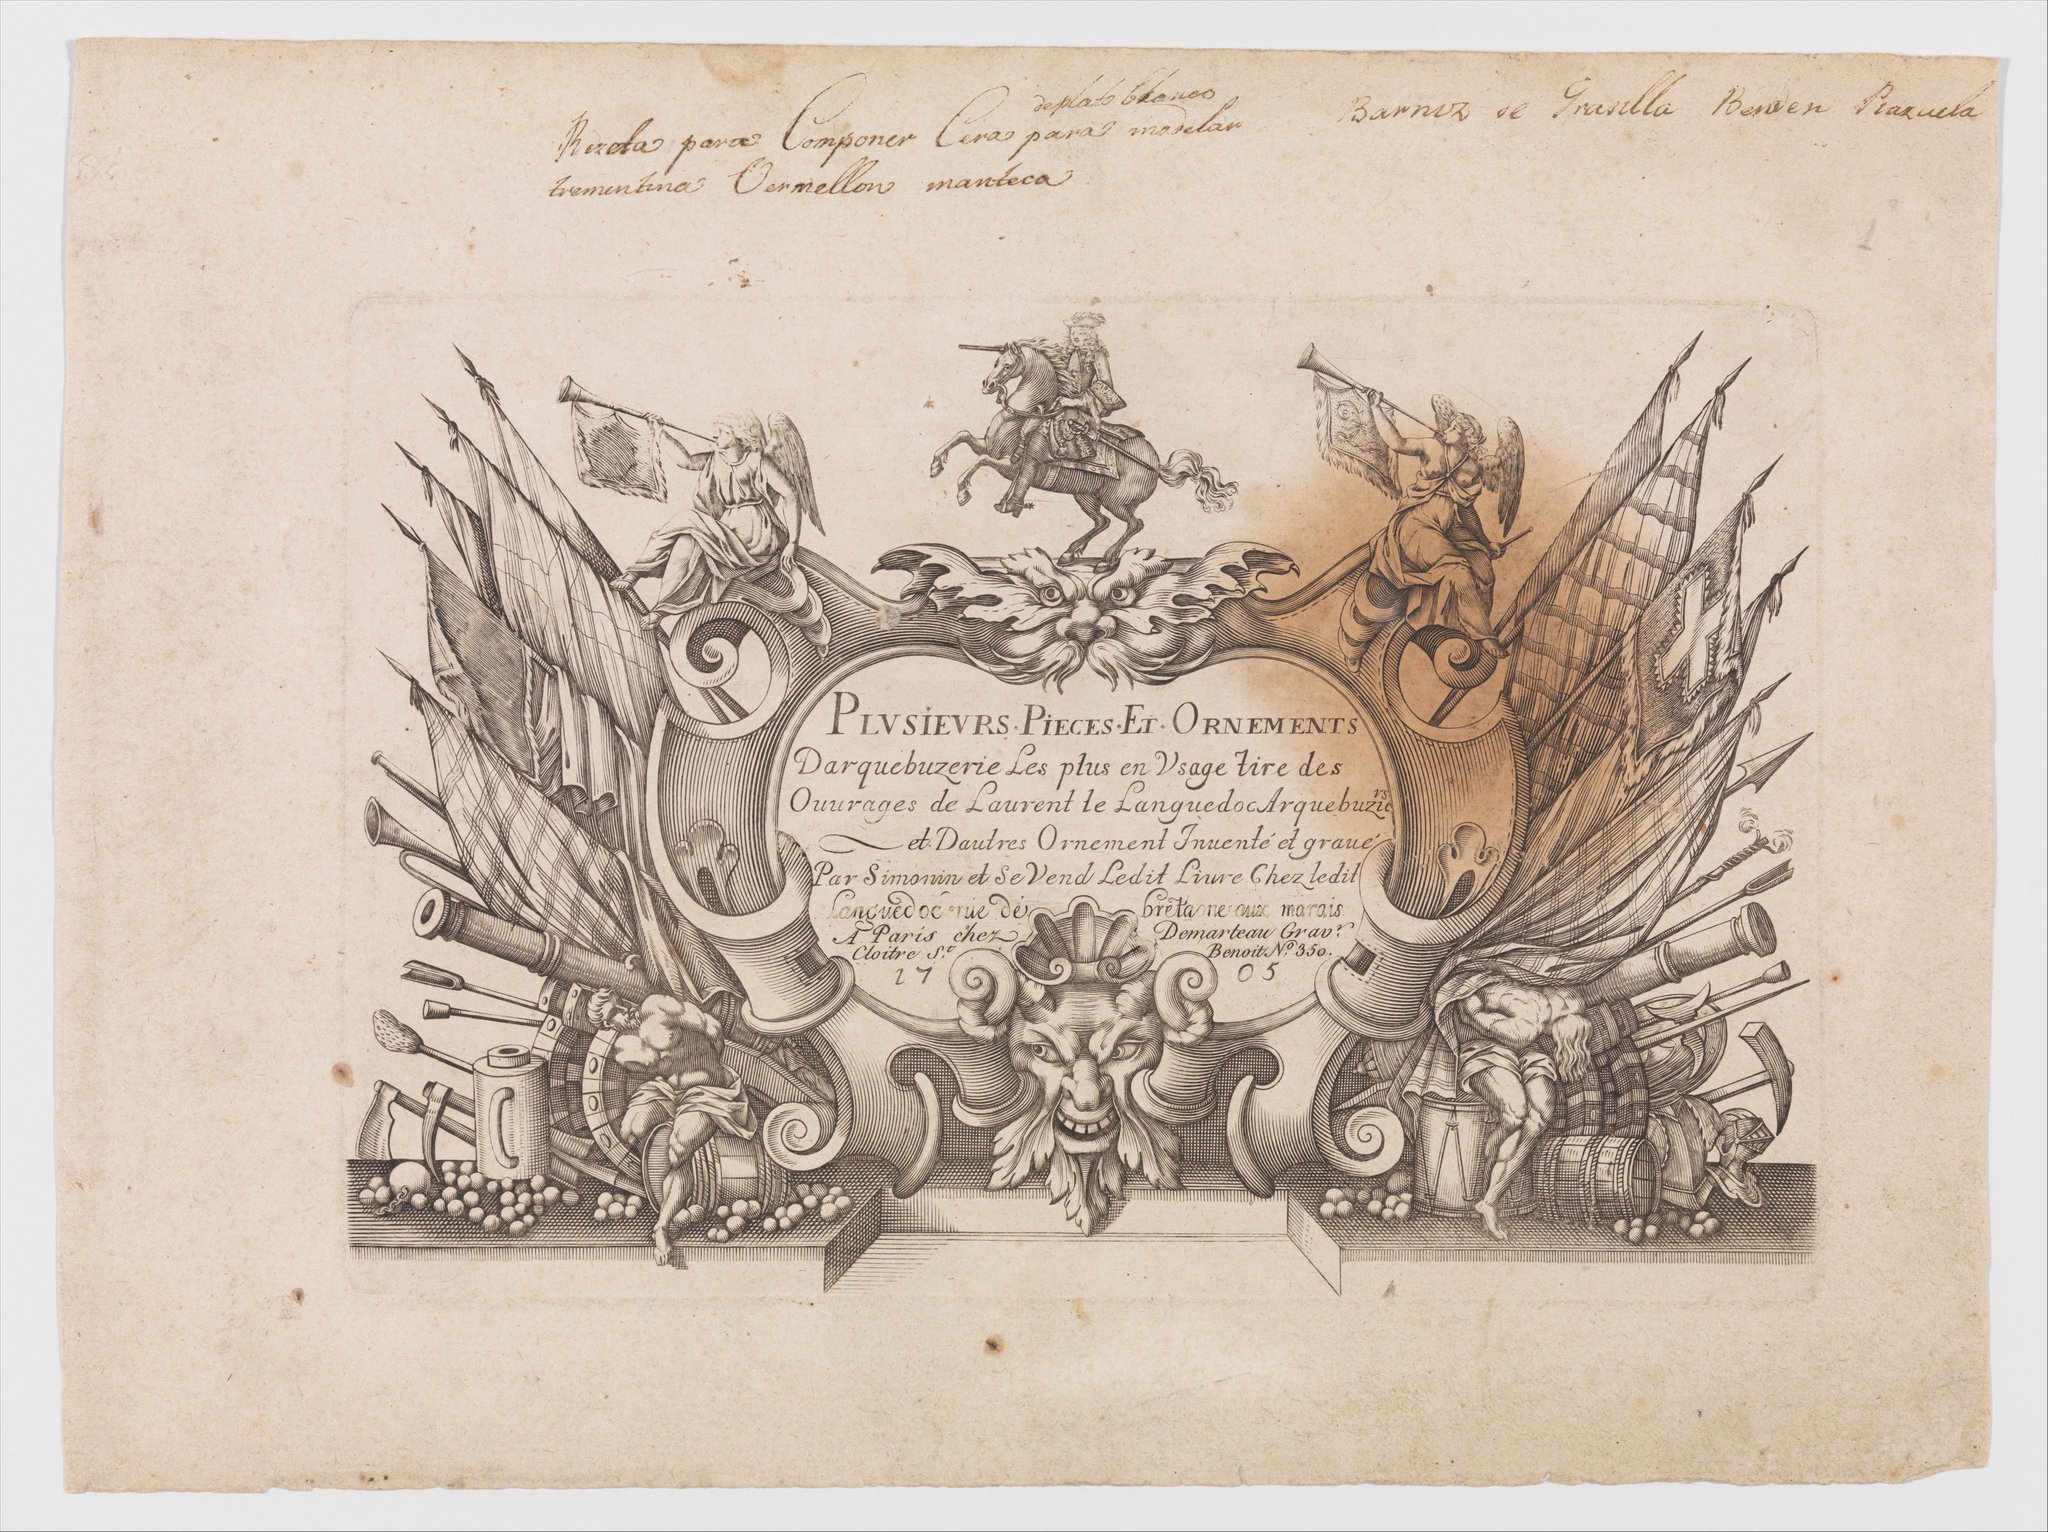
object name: pattern book of firearm ornament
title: Plusievrs Pieces et Ornements Darquebuzerie (4th extended edition)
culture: french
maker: claude simonin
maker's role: engraver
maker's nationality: french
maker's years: 1635-1693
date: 1776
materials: ink, paper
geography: france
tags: firearms,ornament